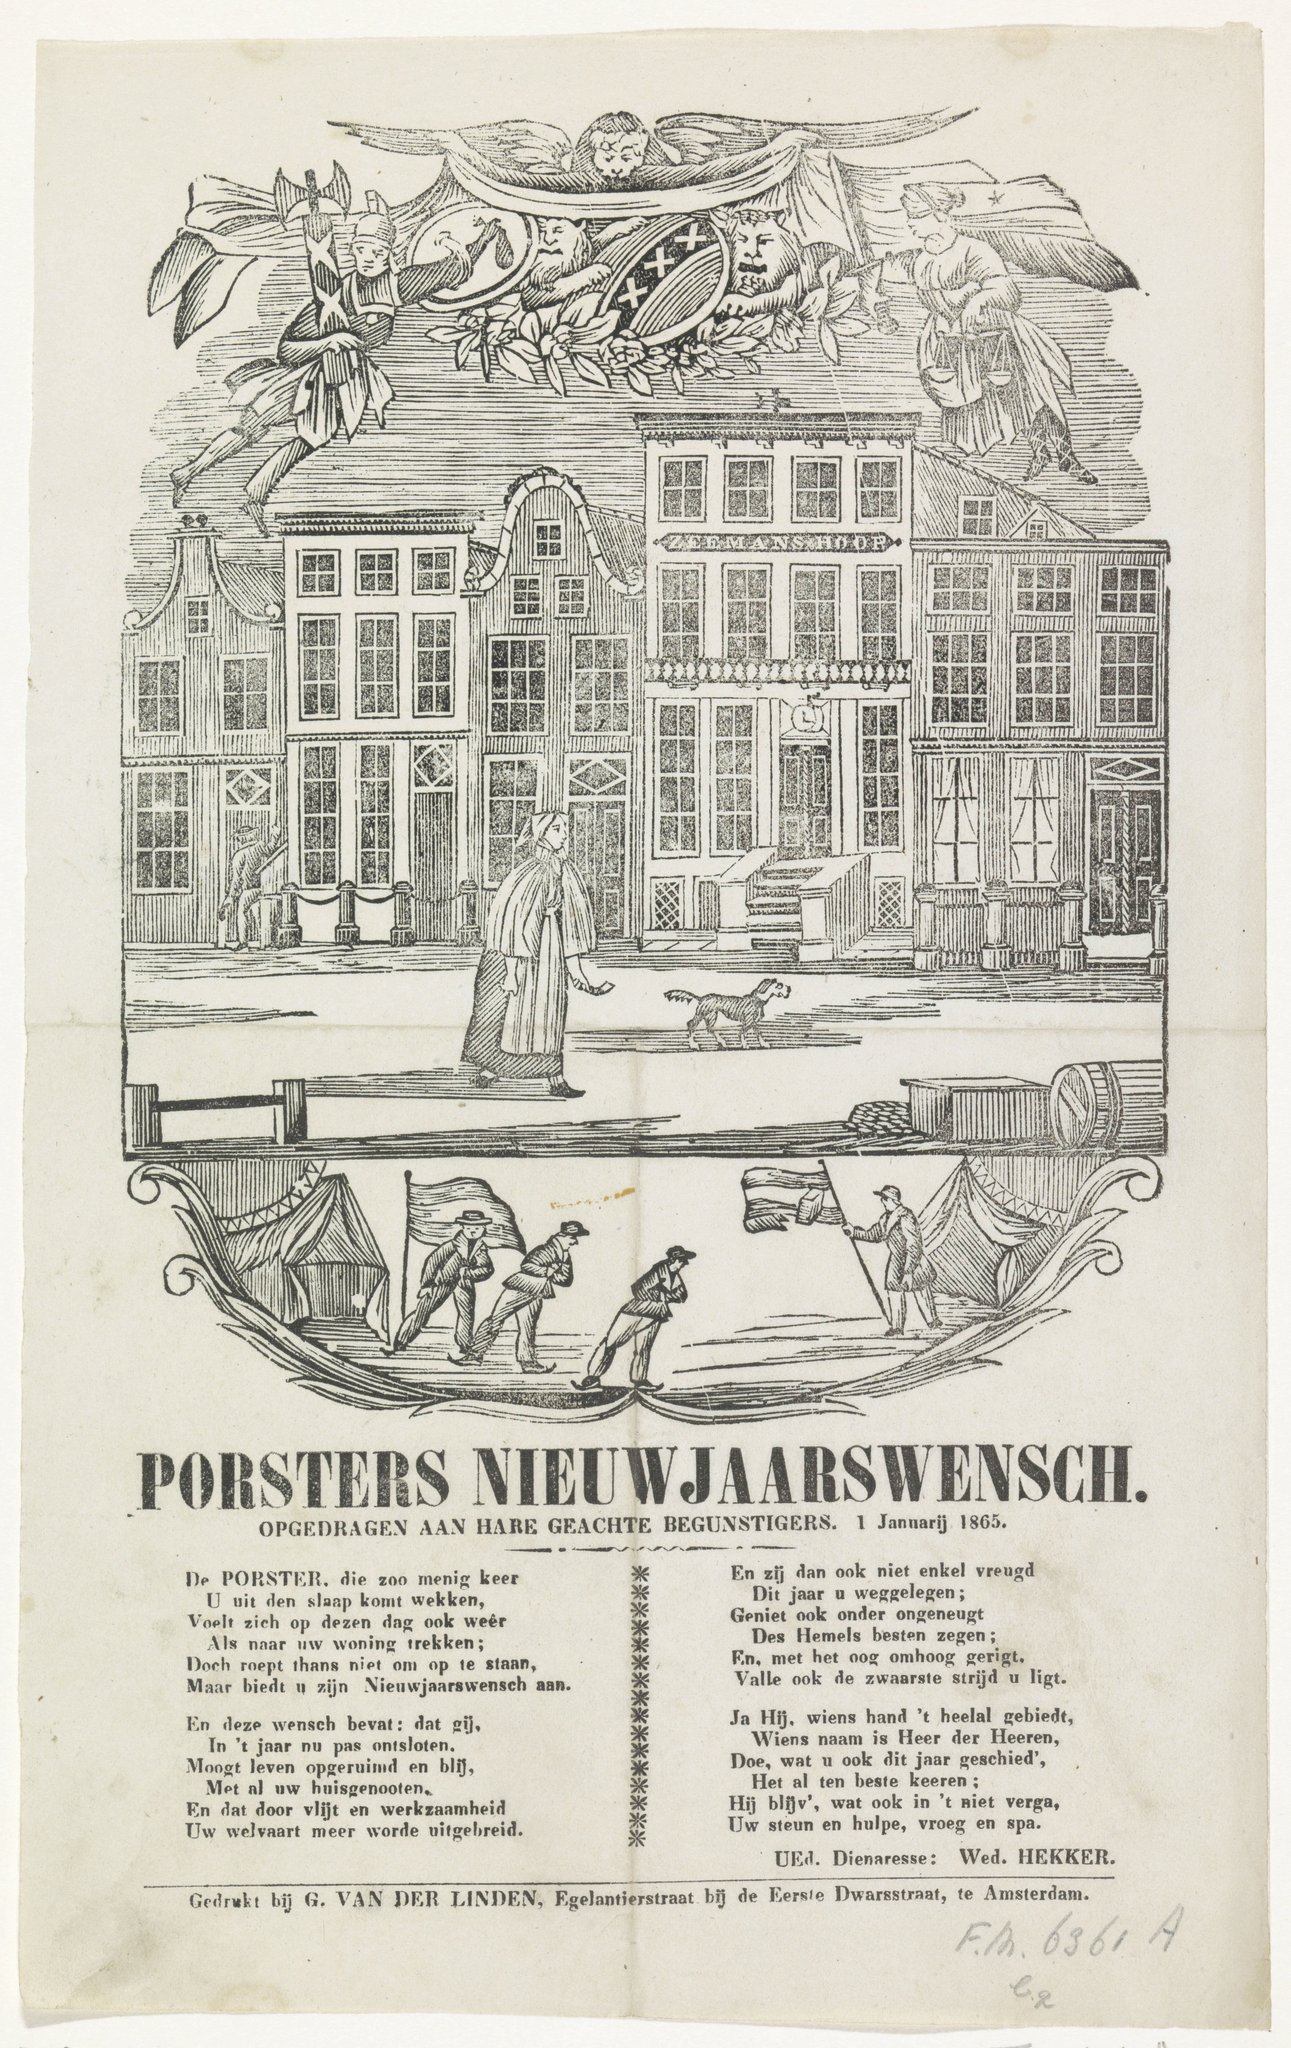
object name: new year card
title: Porsters Nieuwjaarswensch (...) aan hare geachte Begunstigers (...) 1865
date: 1864-1865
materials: paper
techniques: letterpress printing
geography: amsterdam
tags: canals, waters (in city) - ii - ideal city, government services, public services, skates (winter sports), waking up, amsterdam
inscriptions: collector's mark: Lugt 2228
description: Nieuwjaarswens van de Amsterdamse porsters (wekkers) voor het jaar 1865. Gezicht op de Buitenkant te Amsterdam met het gebouw Zeemanshoop, een vrouw loopt met een hond over straat en een man klopt bij een huis aan de deur. Bovenaan een allegorisch vignet met het stadswapen. Onderaan enkele schaatsers op het ijs. Met een vers in twee kolommen. Namens de porster wed. Hekker.